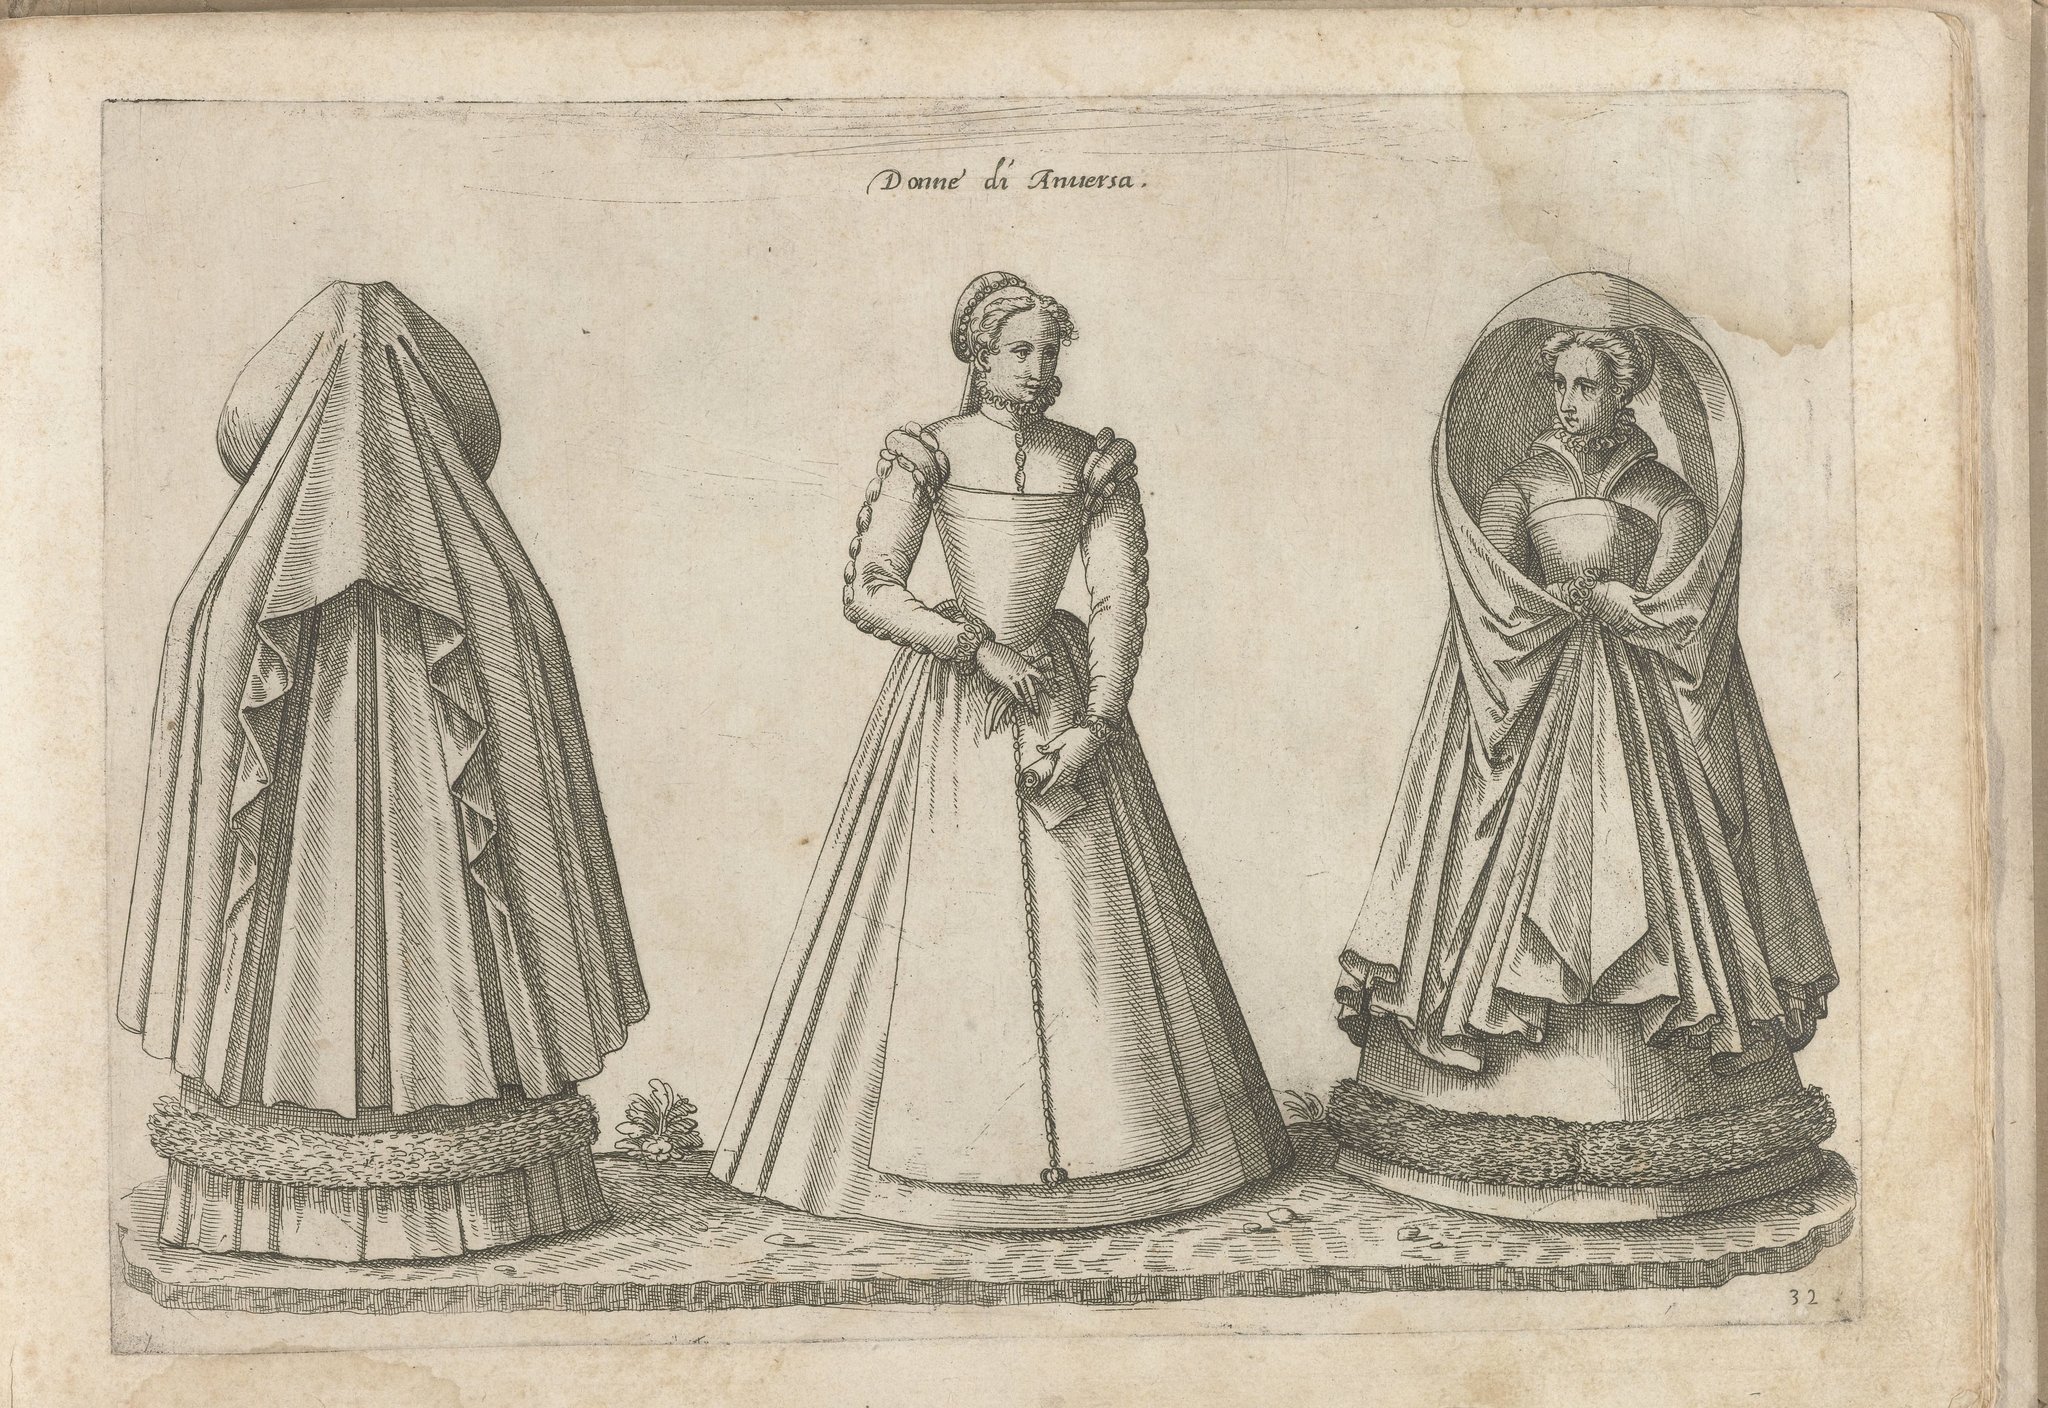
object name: costume print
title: Donne di Anversa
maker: bartolomeo grassi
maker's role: publisher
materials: paper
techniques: engraving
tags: europeans (flemings) (+ costume), cape (huik) (+ women's clothes), dress, gown (+ women's clothes)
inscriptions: number: ‘31’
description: Links en rechts vrouw in huis, links op de rug gezien. Prent nr. 32 uit album 'Dei veri ritratti degl'habiti di tvtte le parti del mondo intagliati in rame per opra di Bartolomeo Grassi', 1585.